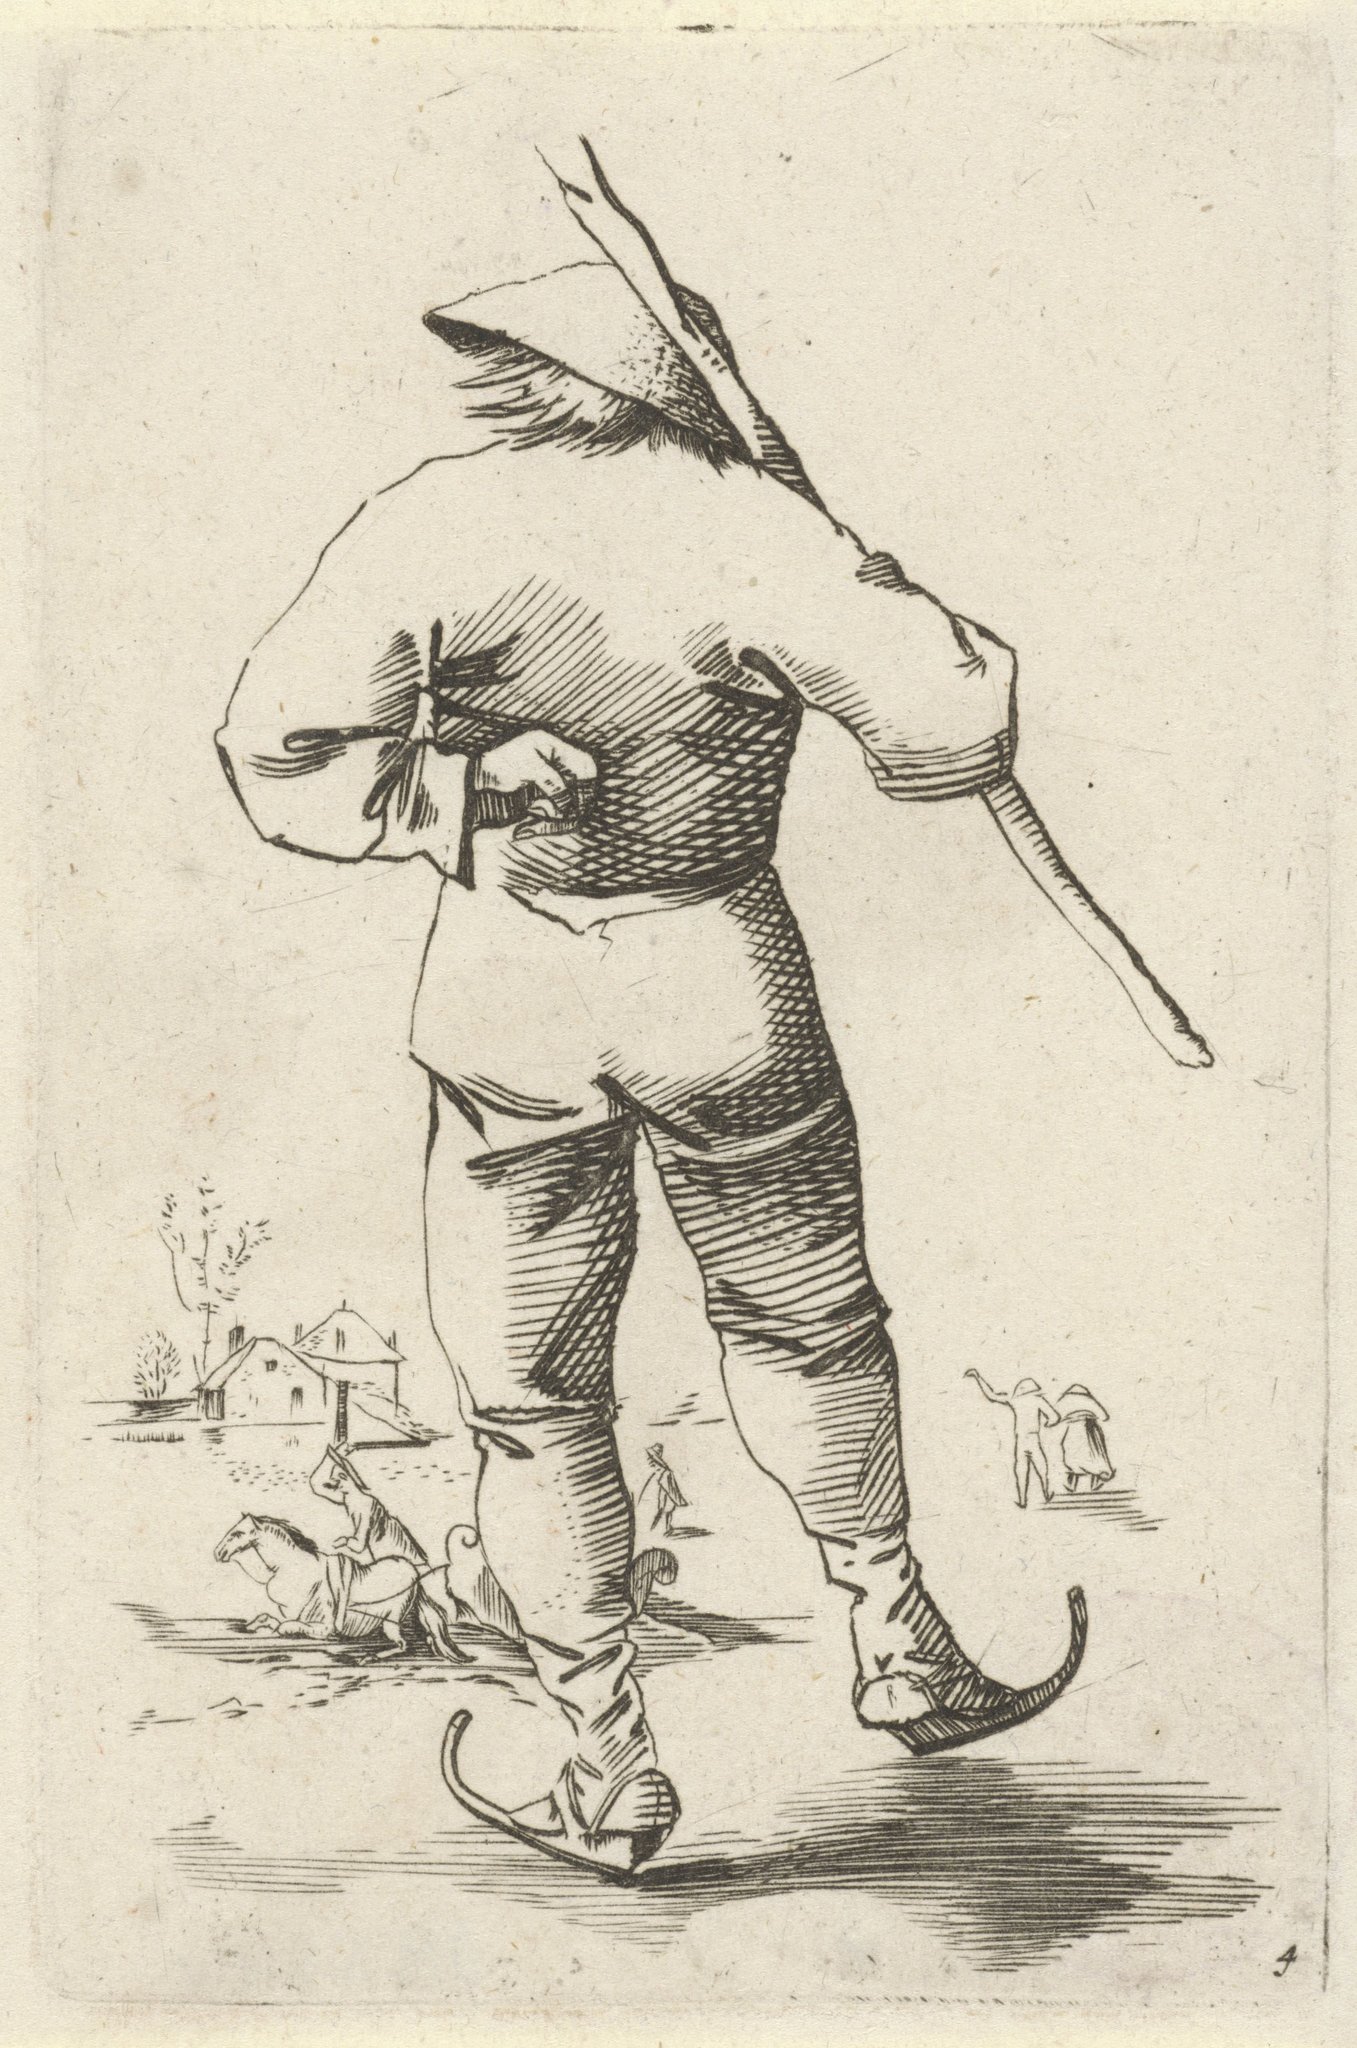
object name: print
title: Schaatsende man, van achteren gezien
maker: Anonymous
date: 1630-1715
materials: paper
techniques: engraving, etching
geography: amsterdam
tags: skates (winter sports)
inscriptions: collector's mark: Lugt 240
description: Spiegelbeeldige kopie naar prent uit de twaalfdelige serie "T'Leven Der Boeren" van Salomon Savery naar Pieter Jansz. Quast.